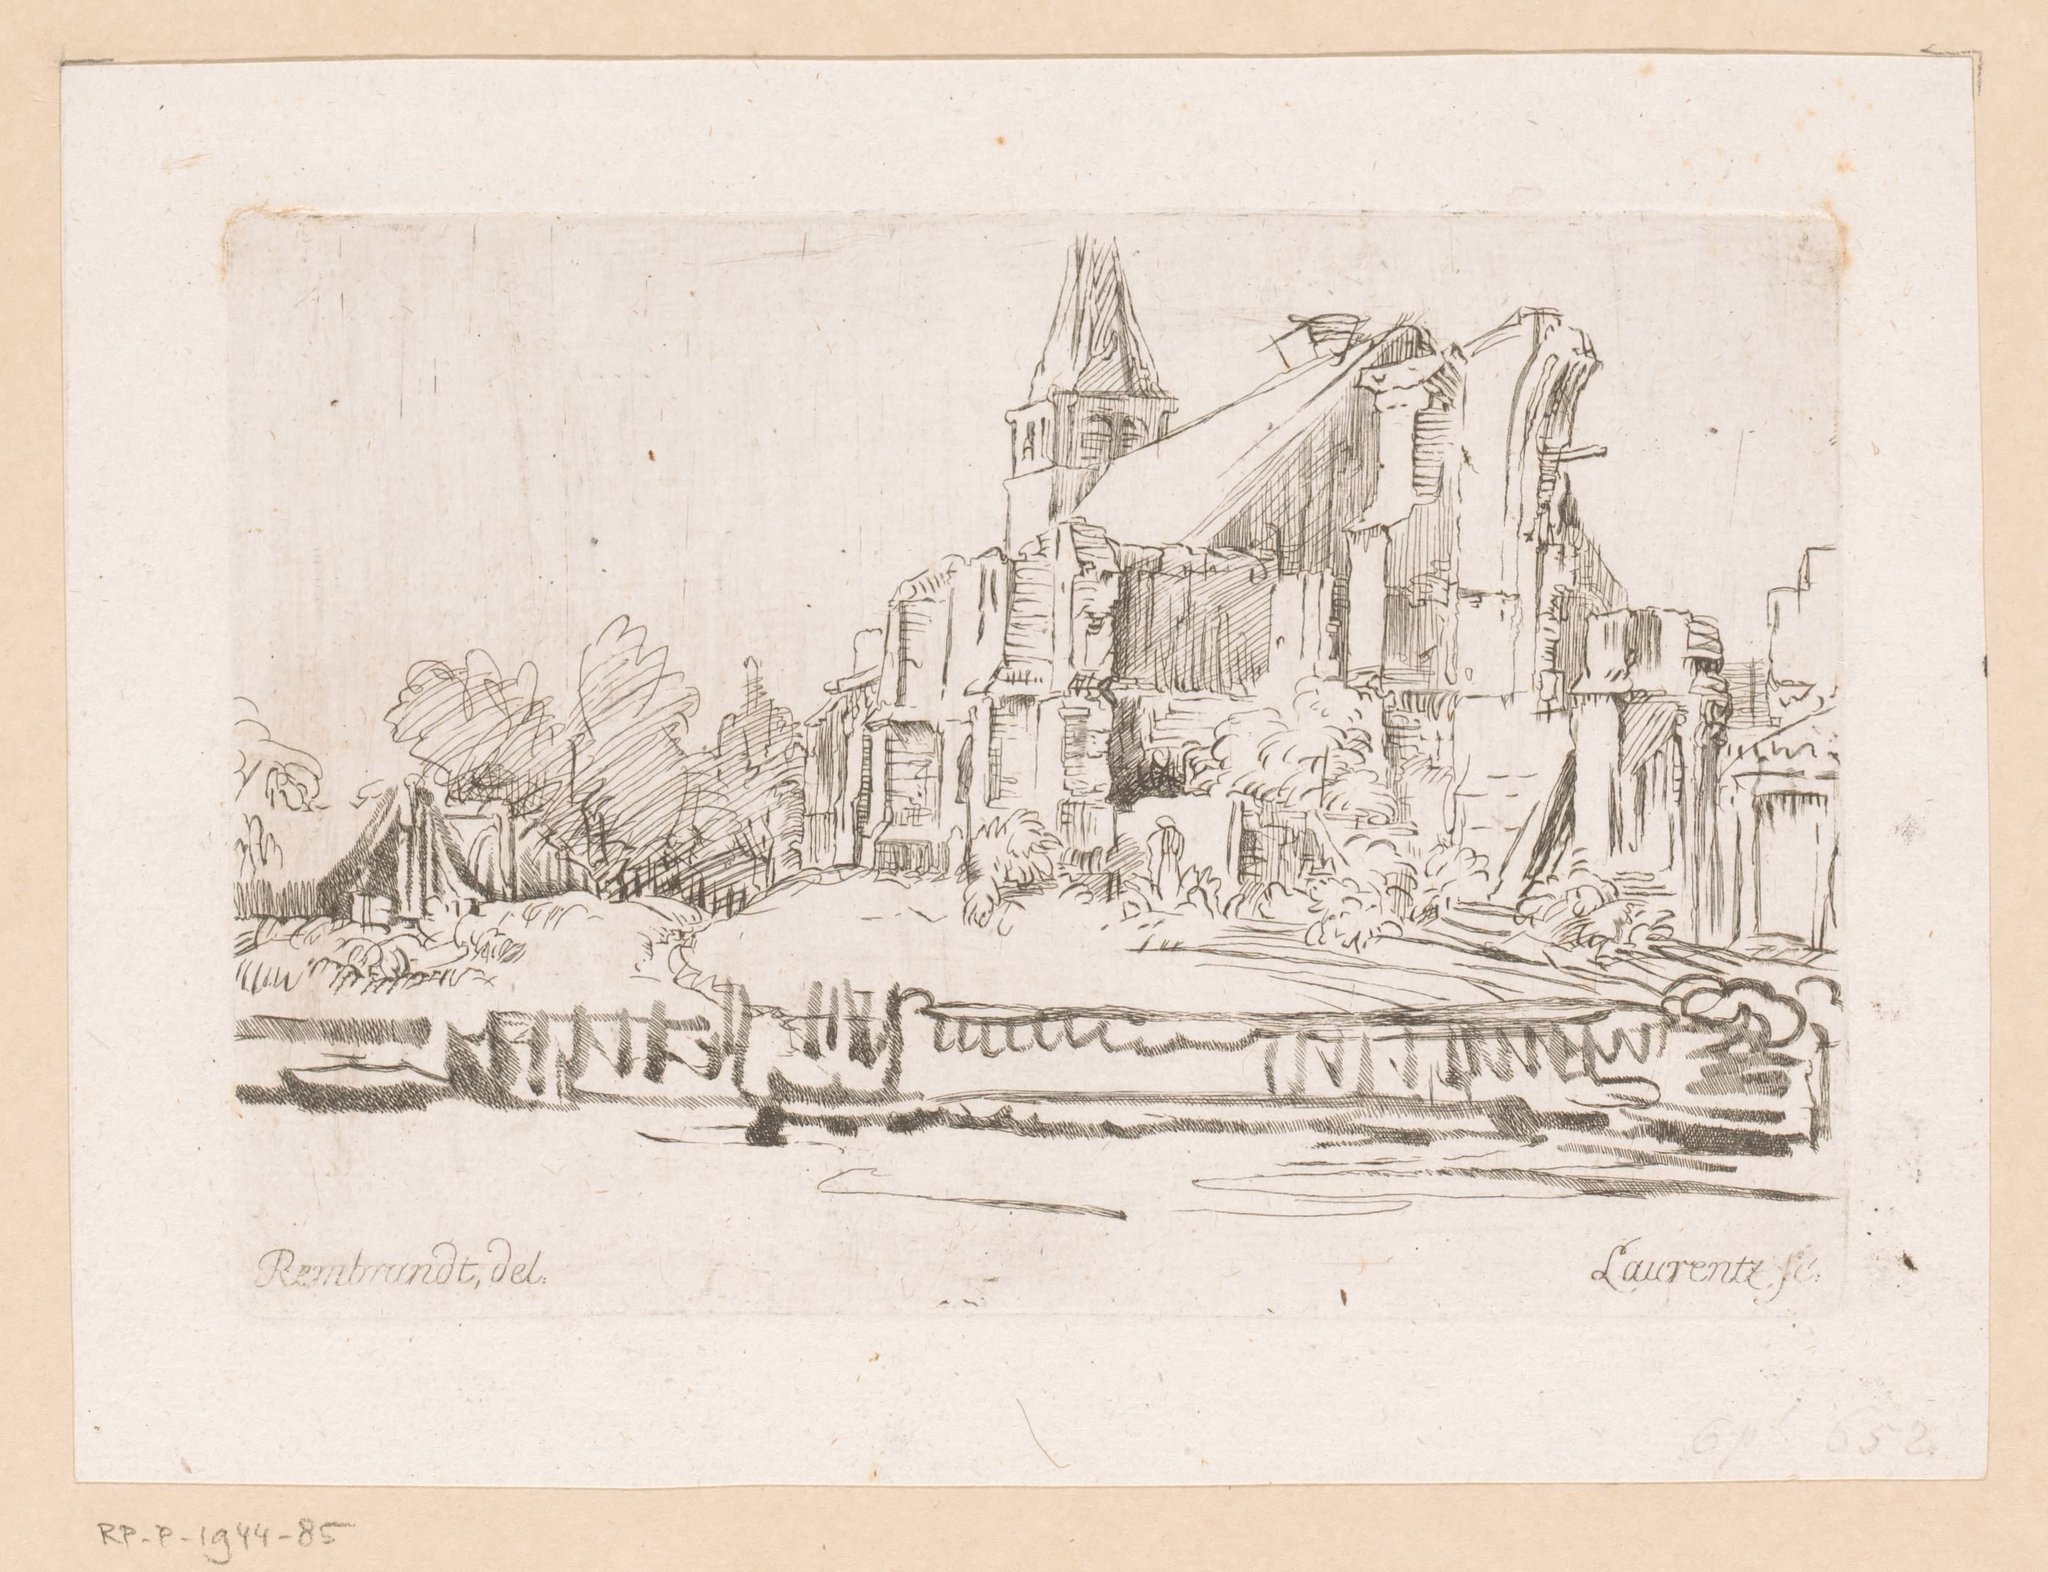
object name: print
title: Gezicht op een ruïne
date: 1739-1810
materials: paper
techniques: etching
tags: landscape with ruins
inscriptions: collector's mark: Lugt 2228